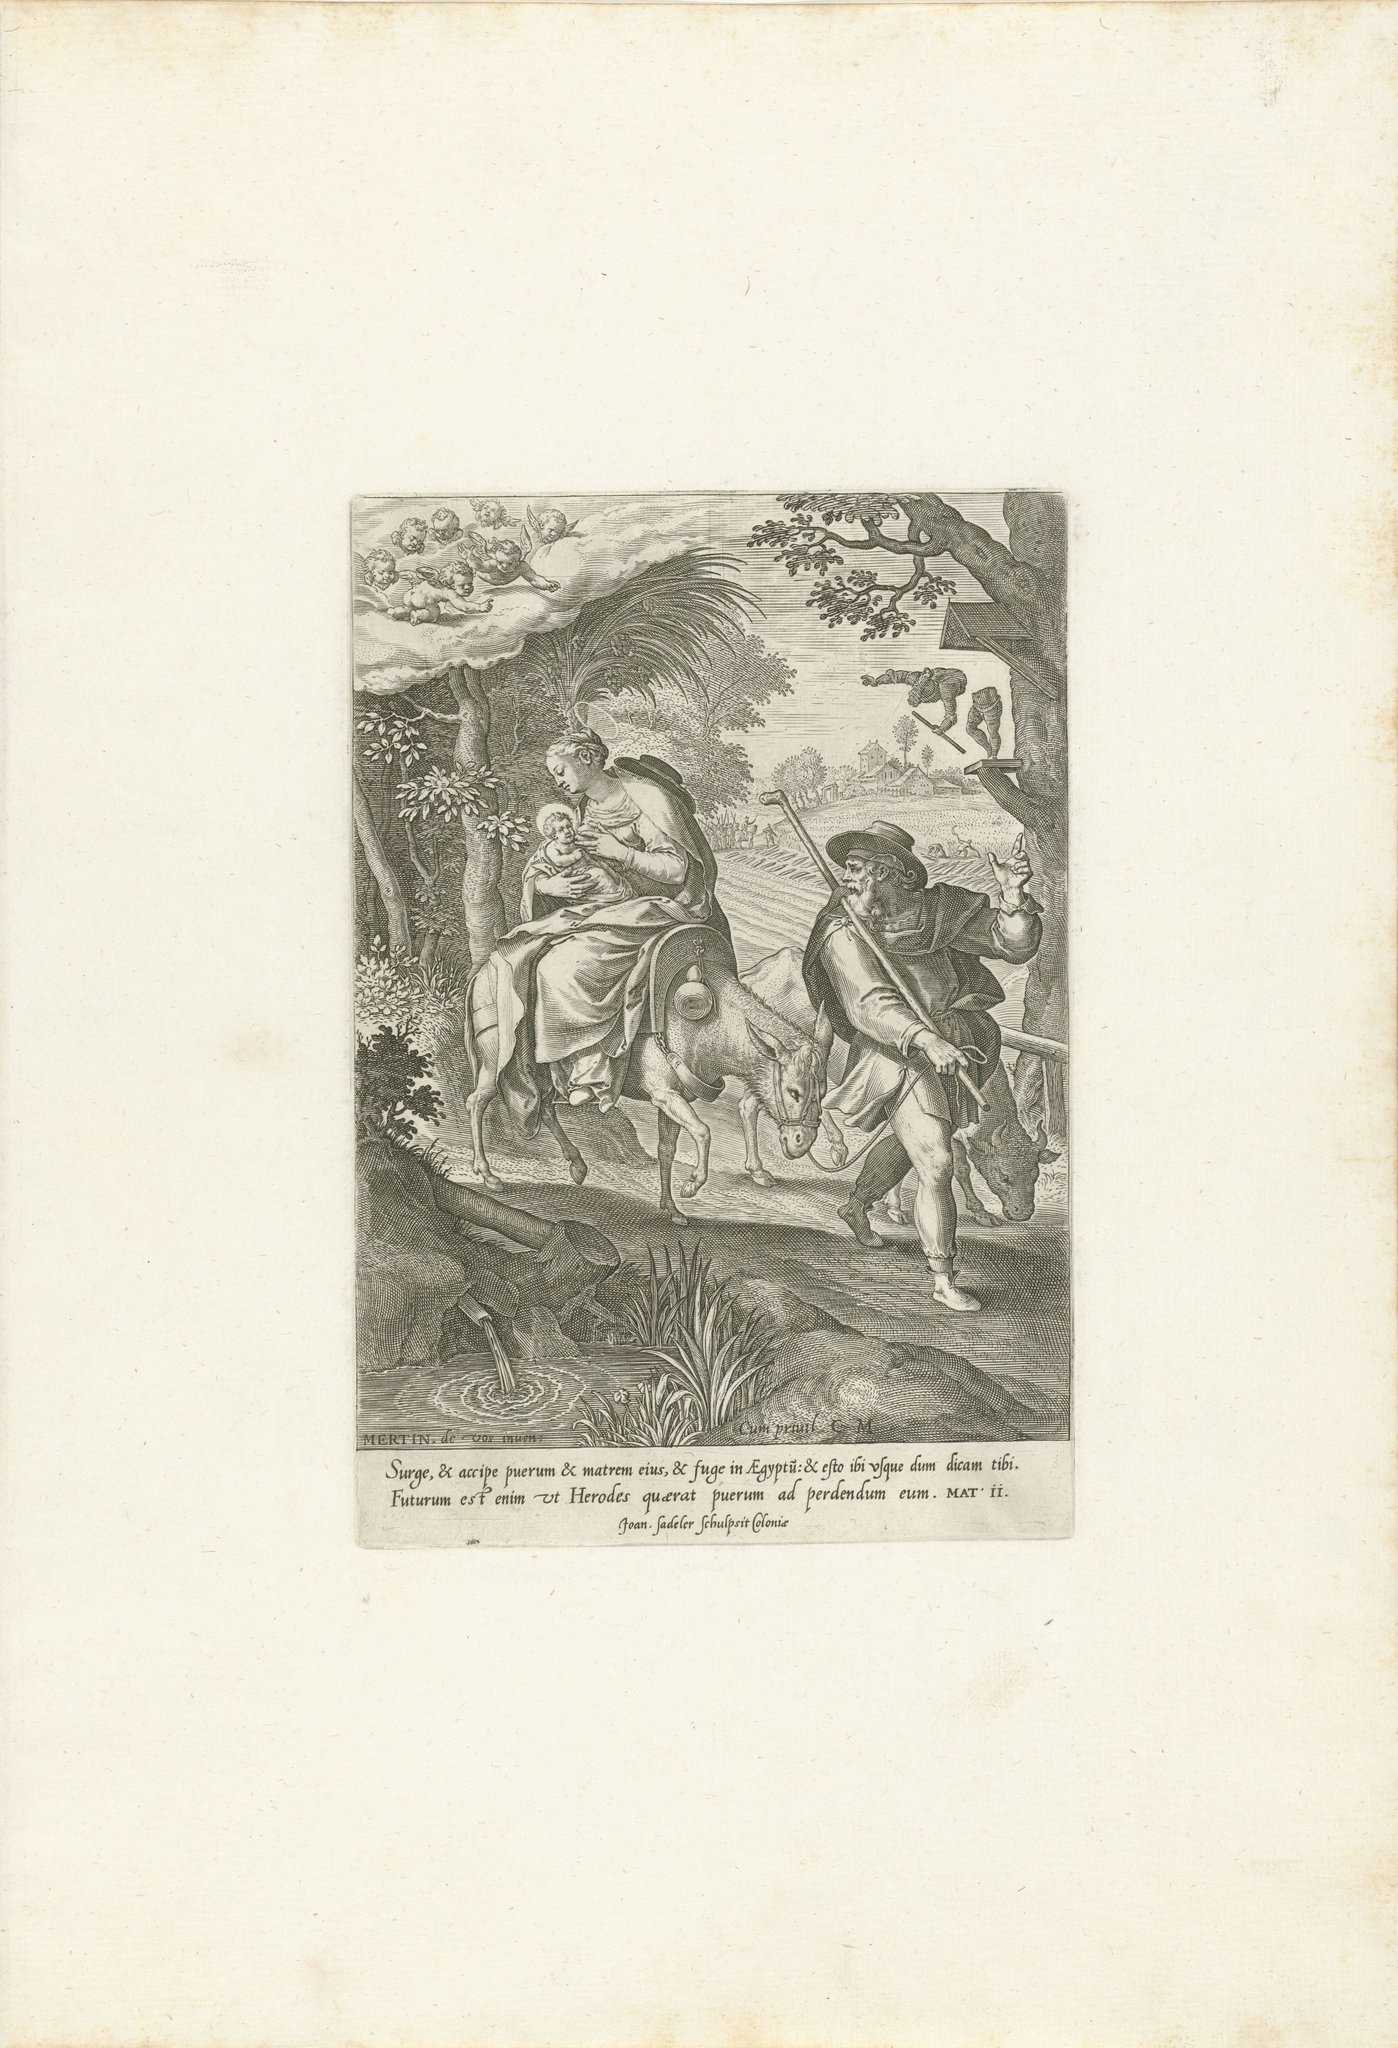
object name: print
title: Vlucht naar Egypte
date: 1579-1582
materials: paper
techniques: engraving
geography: cologne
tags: falling of the idols ~ miracles during the flight into egypt, flight into egypt and miracles during the journey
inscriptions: collector's mark: Lugt 2760, collector's mark: Lugt 2228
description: De Heilige Familie op reis naar Egypte. Jozef te voet en Maria met het Christuskind in de armen op een ezel. Rechtsboven in een kapel aan een boom breekt een godenbeeld in tweeën. Linksboven een groep engelen in de hemel. Op de achtergrond een korenveld met maaiers en het leger van Herodes dat naar het Christuskind zoekt. De prent heeft een Latijns Bijbelcitaat als onderschrift en is de achtste prent van een twaalfdelige serie over de geboorte en de eerste jaren van Christus.